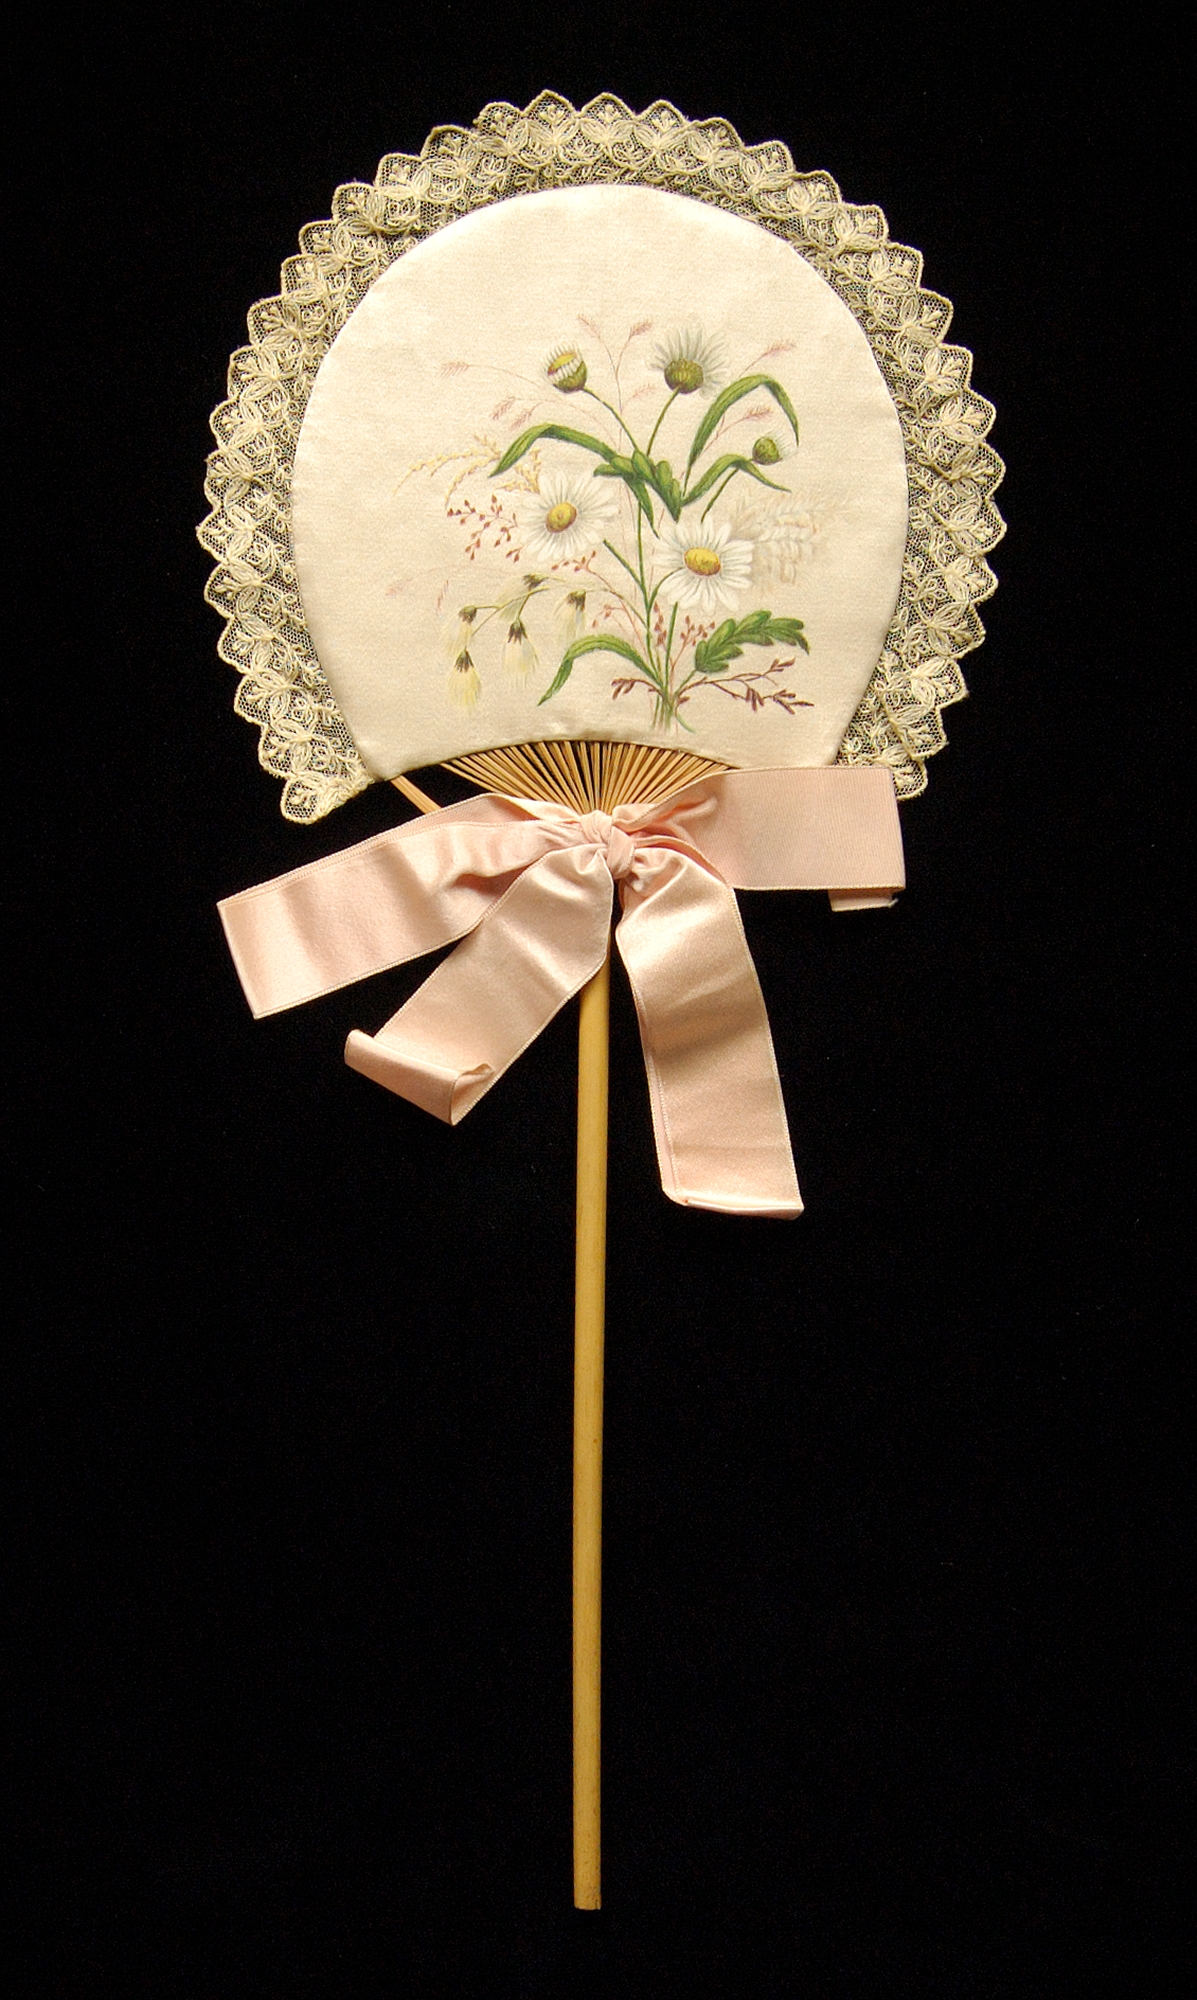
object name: fixed fan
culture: american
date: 1880-1889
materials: cotton, silk, wood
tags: flowers